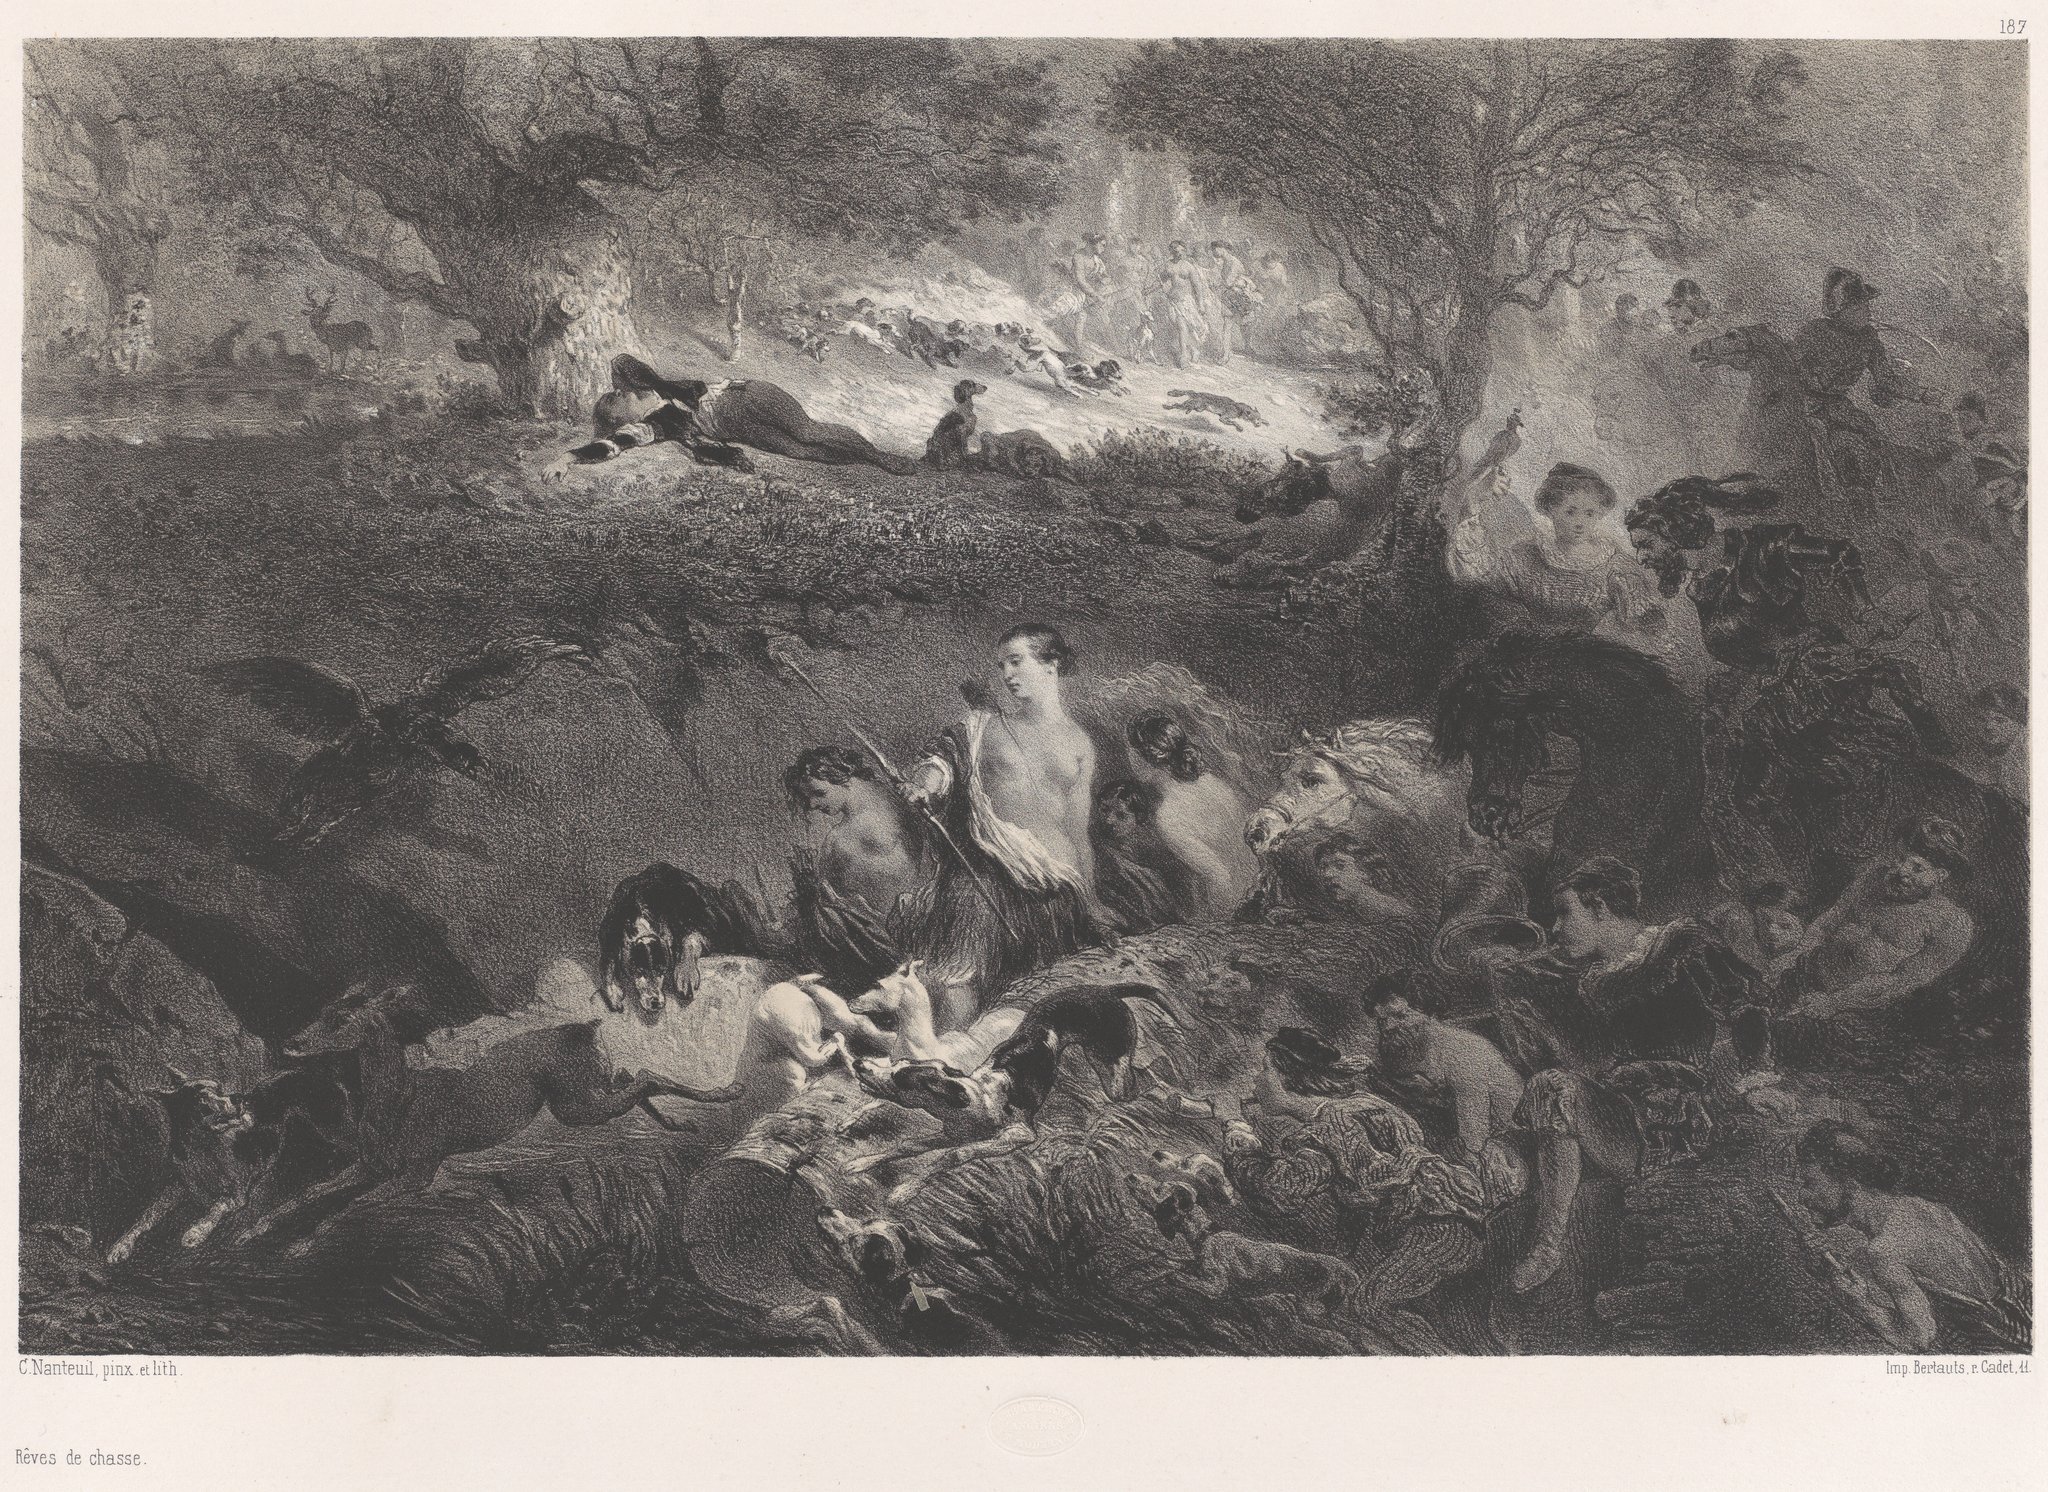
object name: print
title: Dreams of Hunting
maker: célestin nanteuil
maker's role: artist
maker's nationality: french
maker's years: 1813-1873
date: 1858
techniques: lithograph